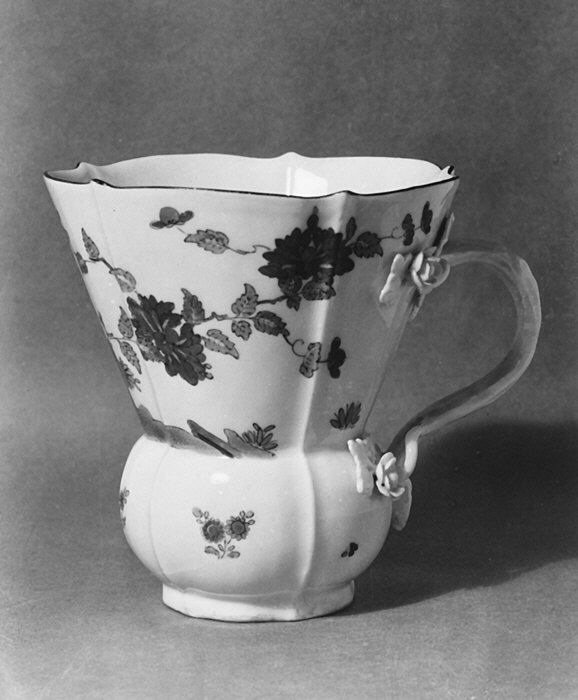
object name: goblet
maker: meissen manufactory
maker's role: manufactory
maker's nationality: german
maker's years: 1710-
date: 1740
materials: hard paste porcelain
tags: flowers